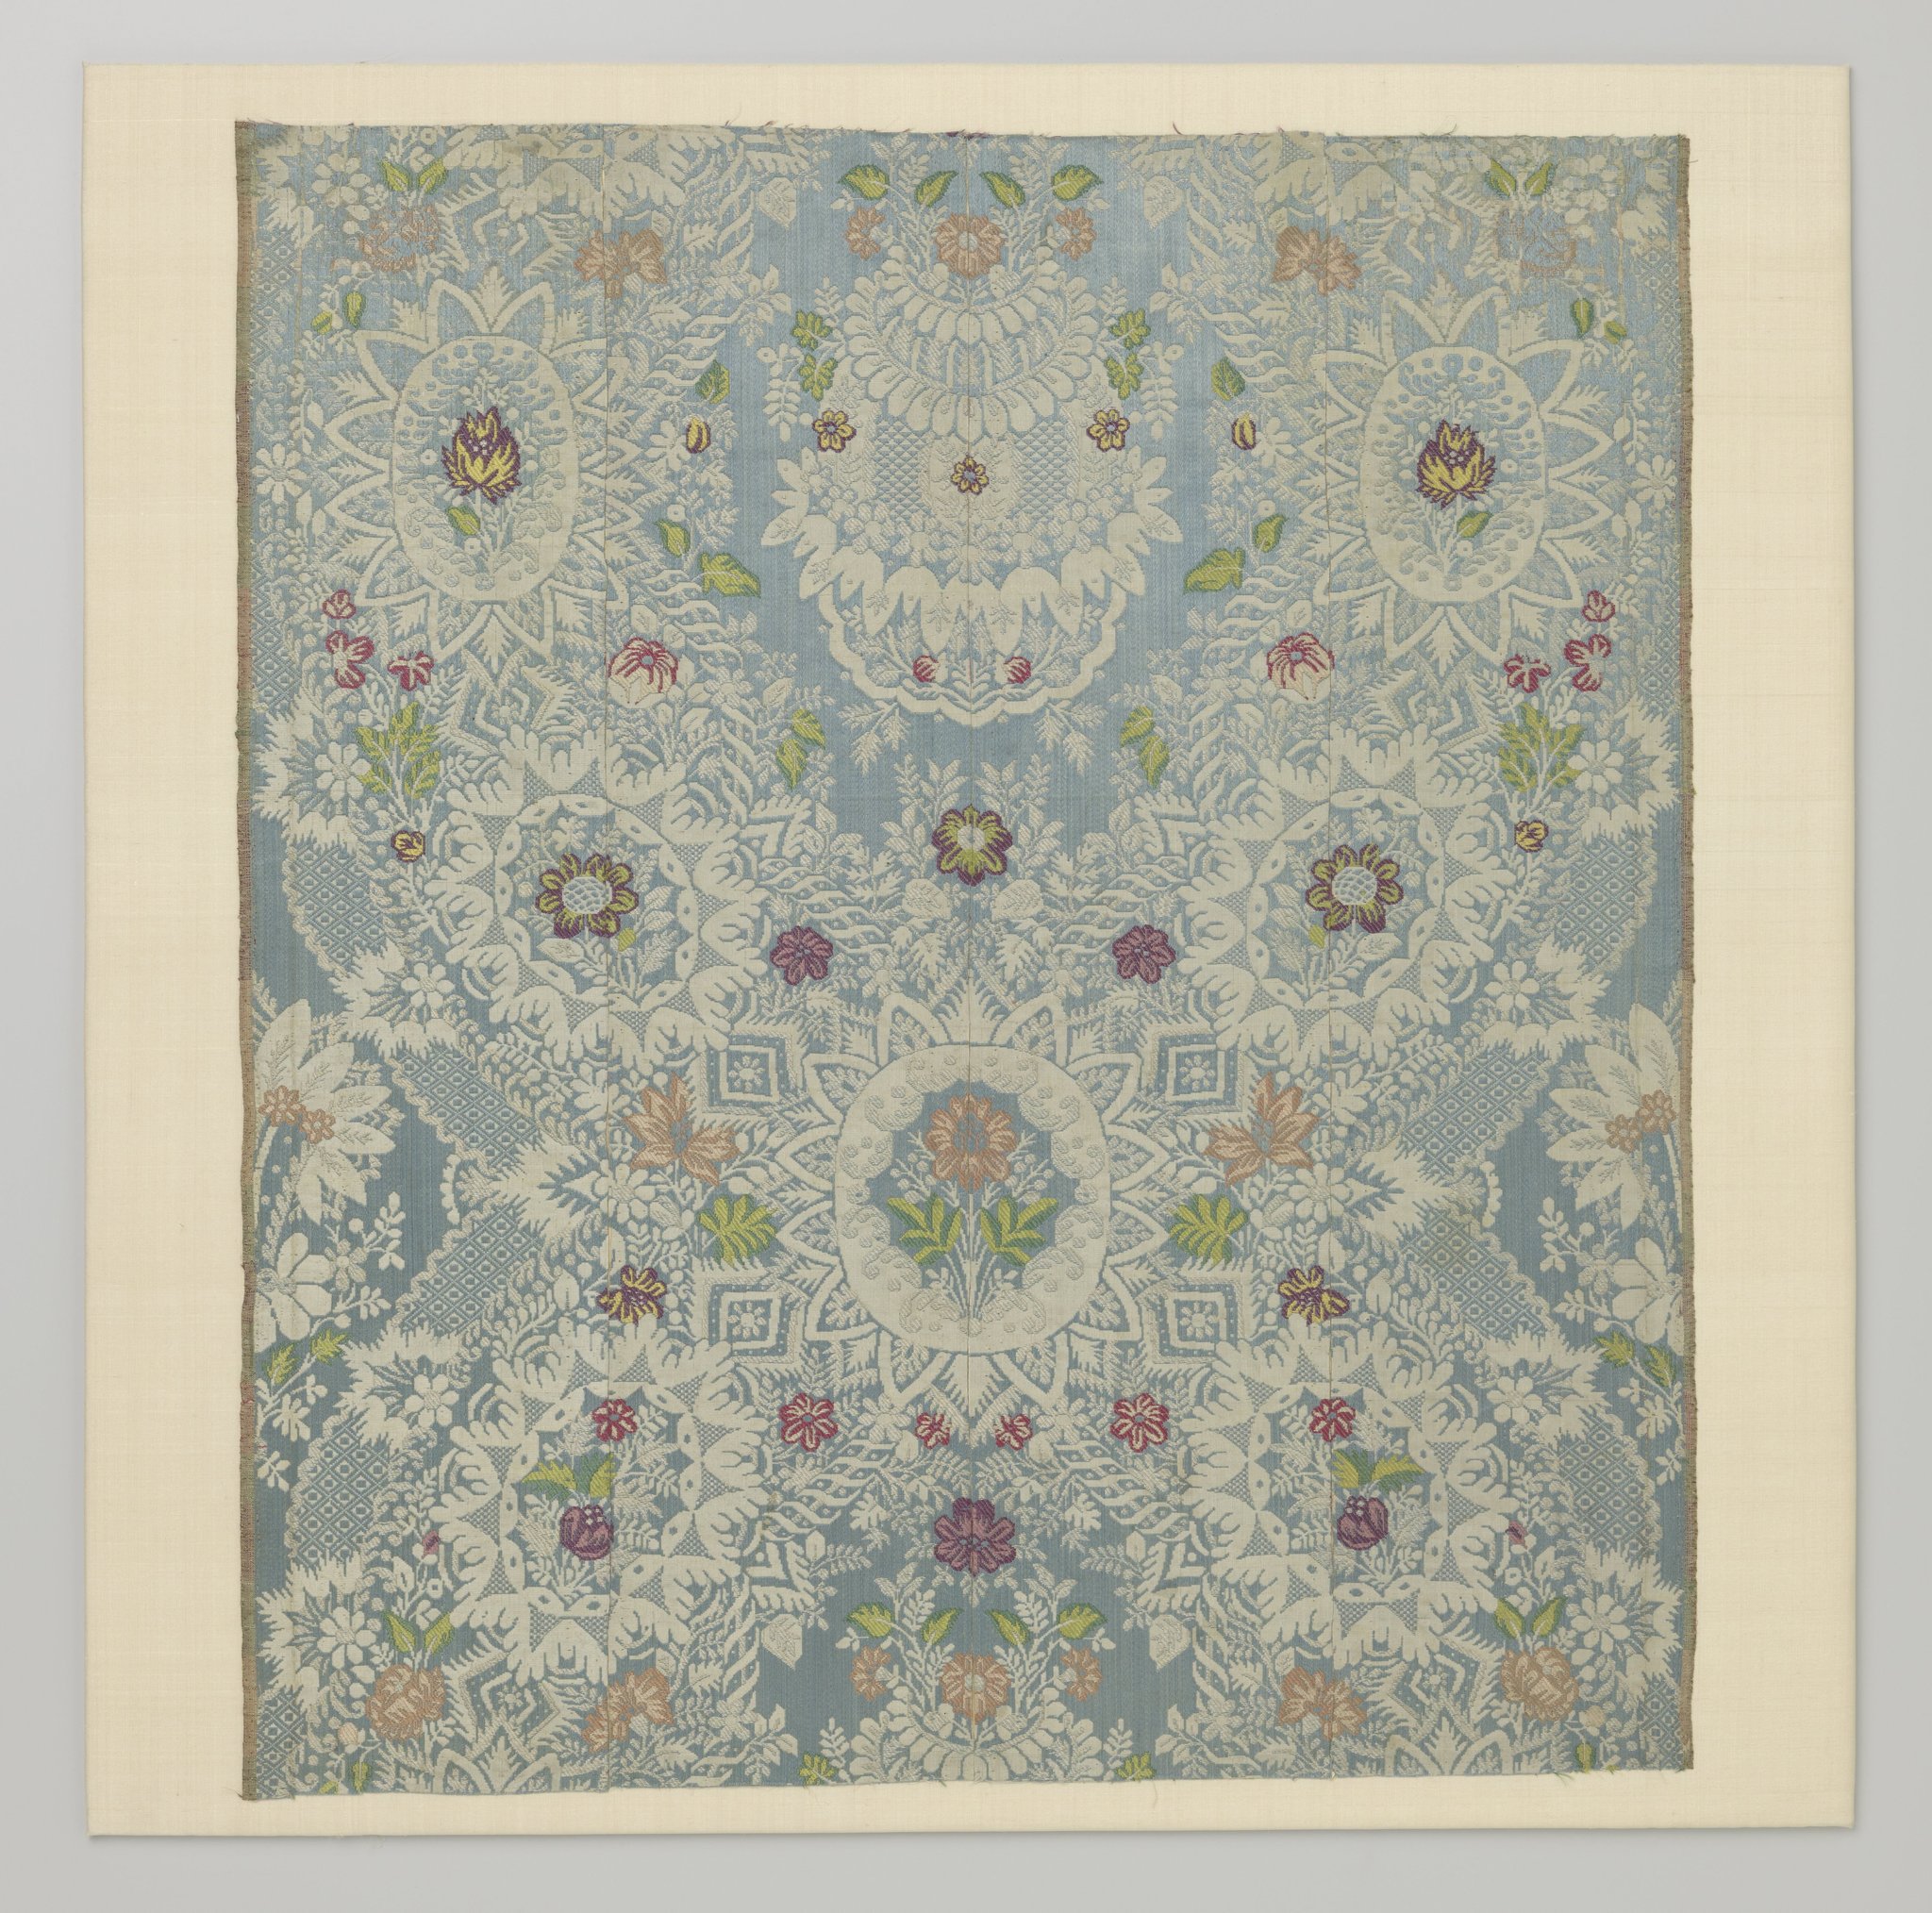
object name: fragment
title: Fragment veelkleurig zijdeweefsel met patroon van elkaar snijdende ovalen, veelkleurige bloemen en zogenaamde kantbanden met dito bloemen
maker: Anonymous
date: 1690-1710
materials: silk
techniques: brocade, lampas, weave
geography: france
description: Fragment veelkleurig zijdeweefsel, samengesteld uit vier aan elkaar gezette stukken. Op een groen-blauwe grond snijden witte "kant-banden" elkaar. De hierdoor ontstane ruimtes zijn gevuld met veelkleurige bloemen. In de kant-banden zijn hier en daar veelkleurige bloemen verwerkt.